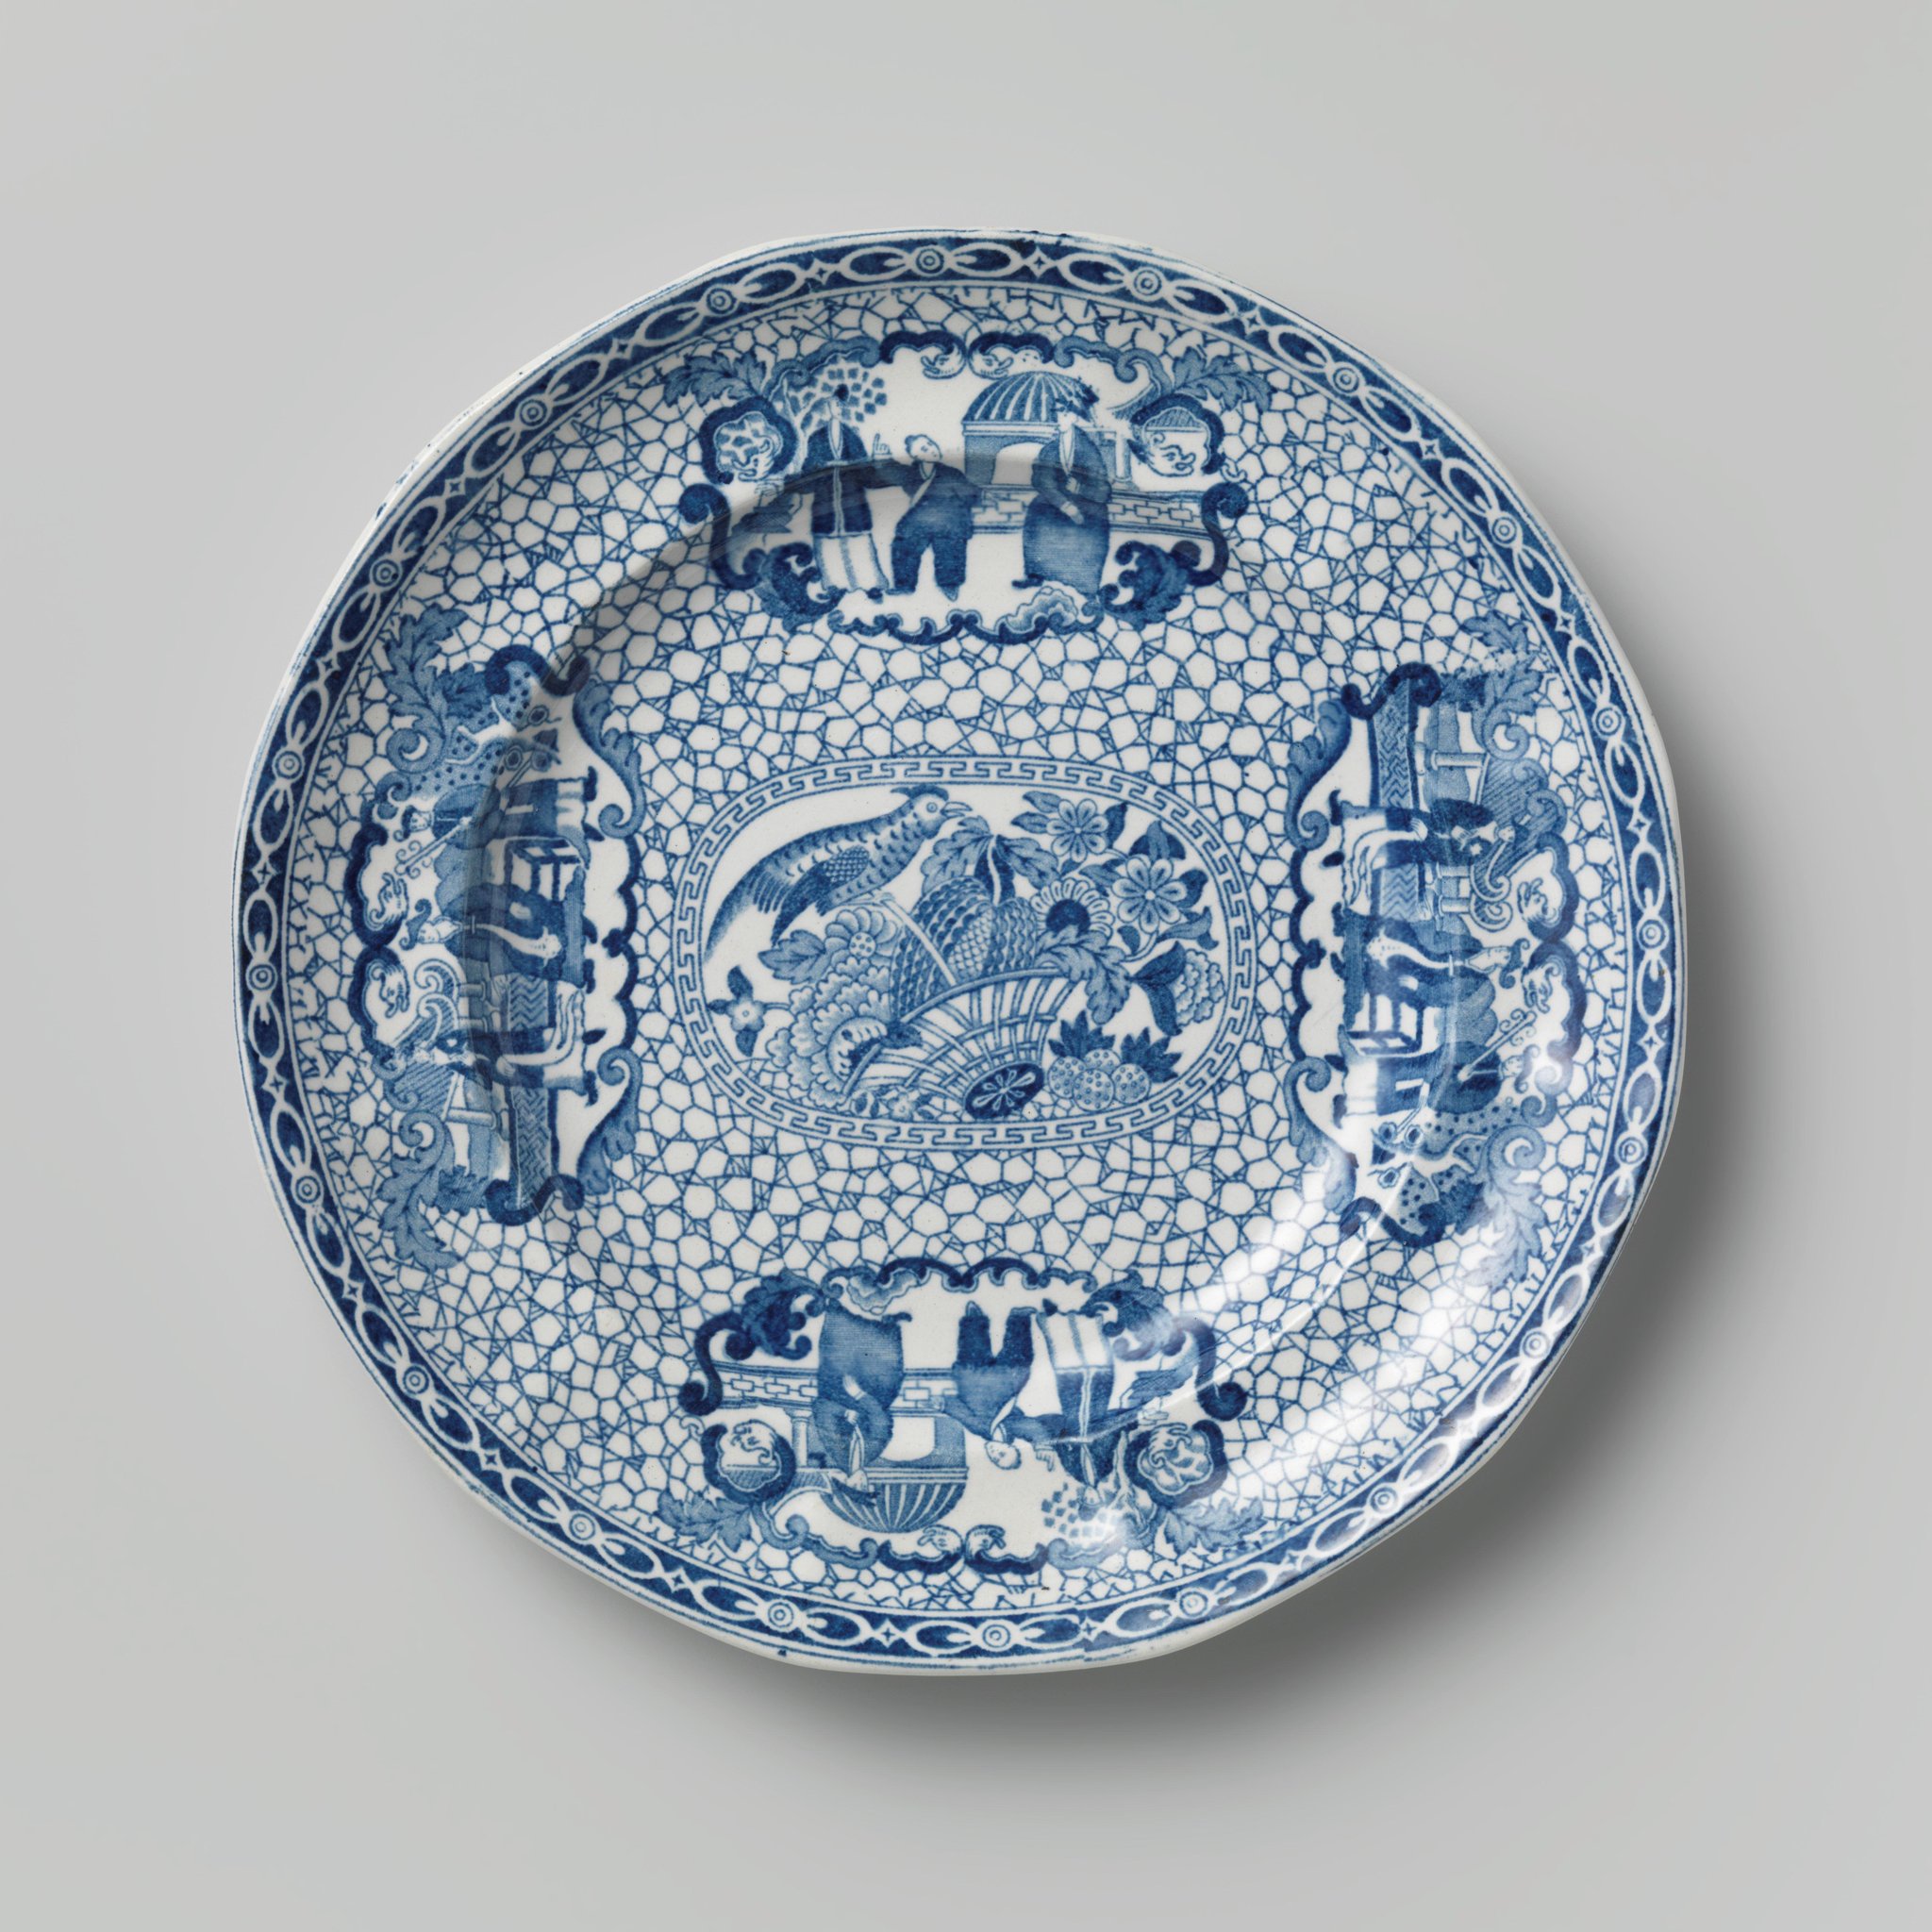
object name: plate dish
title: Rond bord van hardgebakken aardewerk met een blauwe decoratie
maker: Anonymous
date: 1920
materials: earthenware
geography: england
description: Rond bord van hardgebakken aardewerk, met een decoratie in blauw. De decoratie bestaat uit een netwerk waarin uitgespaard vier medaillons op de rand en een medaillon in het midden. Binnen het medaillon in het midden is een omgevallen mand met vruchten en bloemen waarbij een vogel geschilderd en in de vier andere medaillons een scène met drie Chinese figuren.